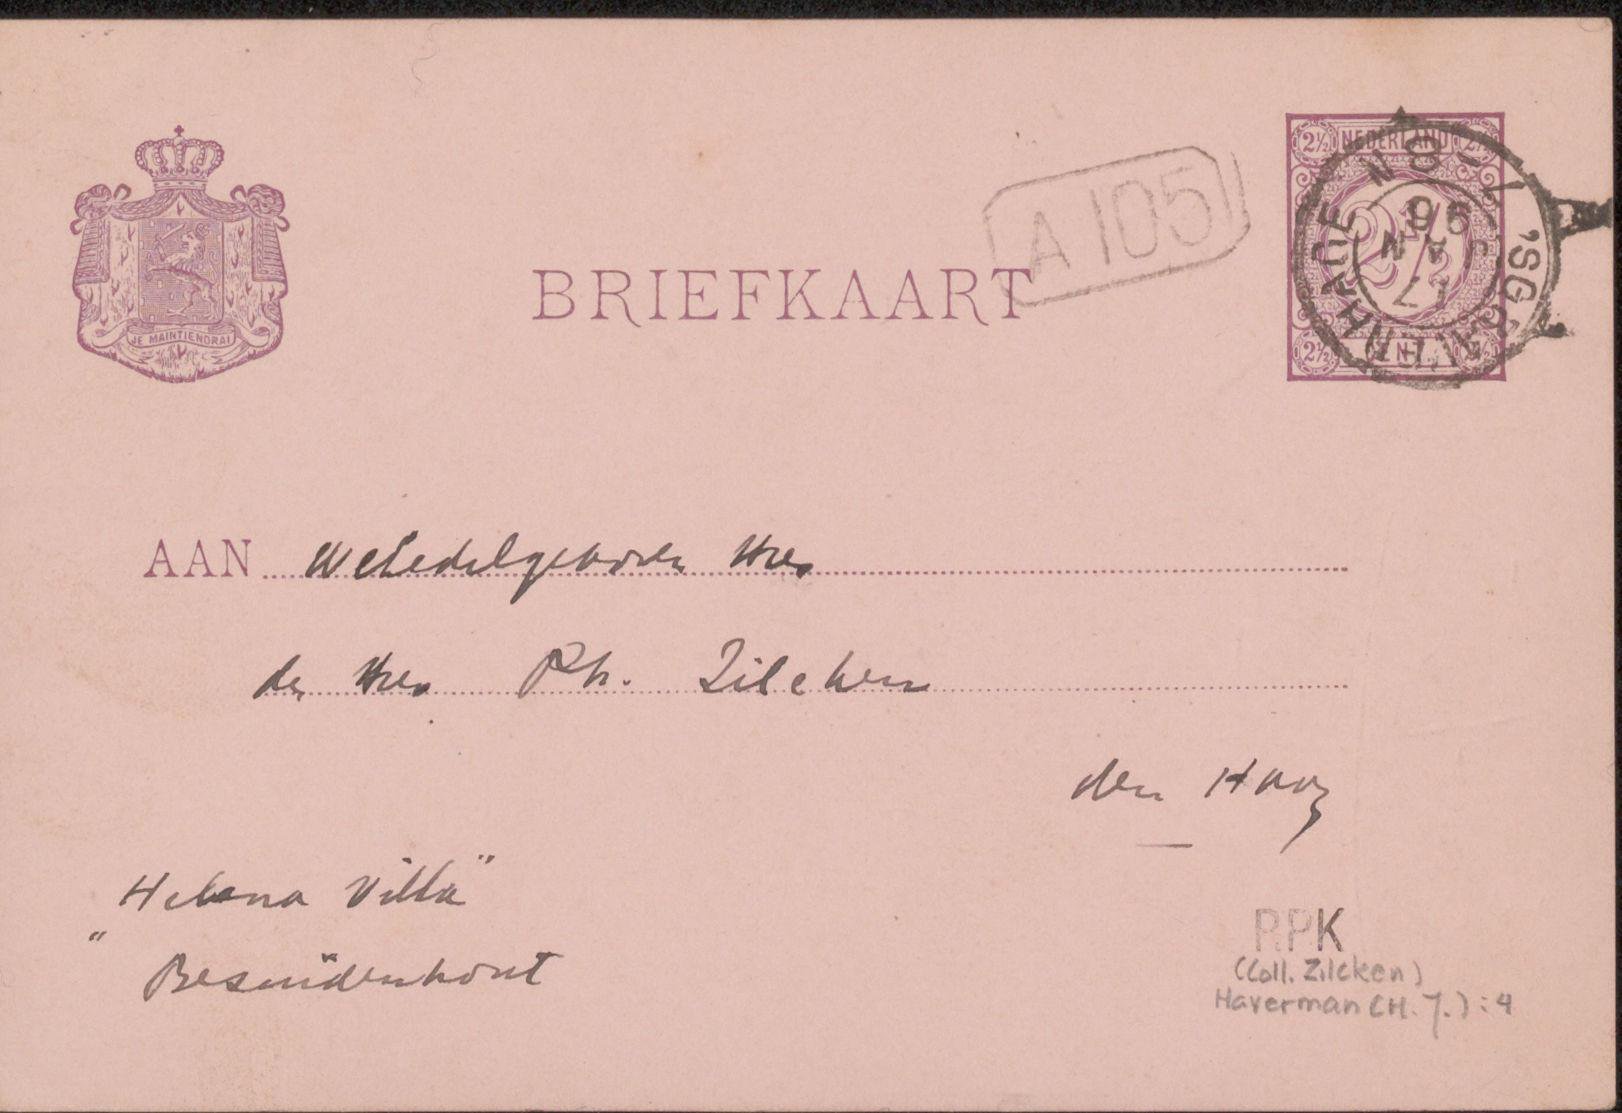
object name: postcard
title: Briefkaart aan Philip Zilcken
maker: hendrik johannes haverman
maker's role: draughtsman, print maker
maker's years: 1857-1928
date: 1896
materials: cardboard, ink, pencil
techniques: pen, writing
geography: the hague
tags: painter, philip zilcken, the graphic arts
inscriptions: collector's mark: ‘RPK’